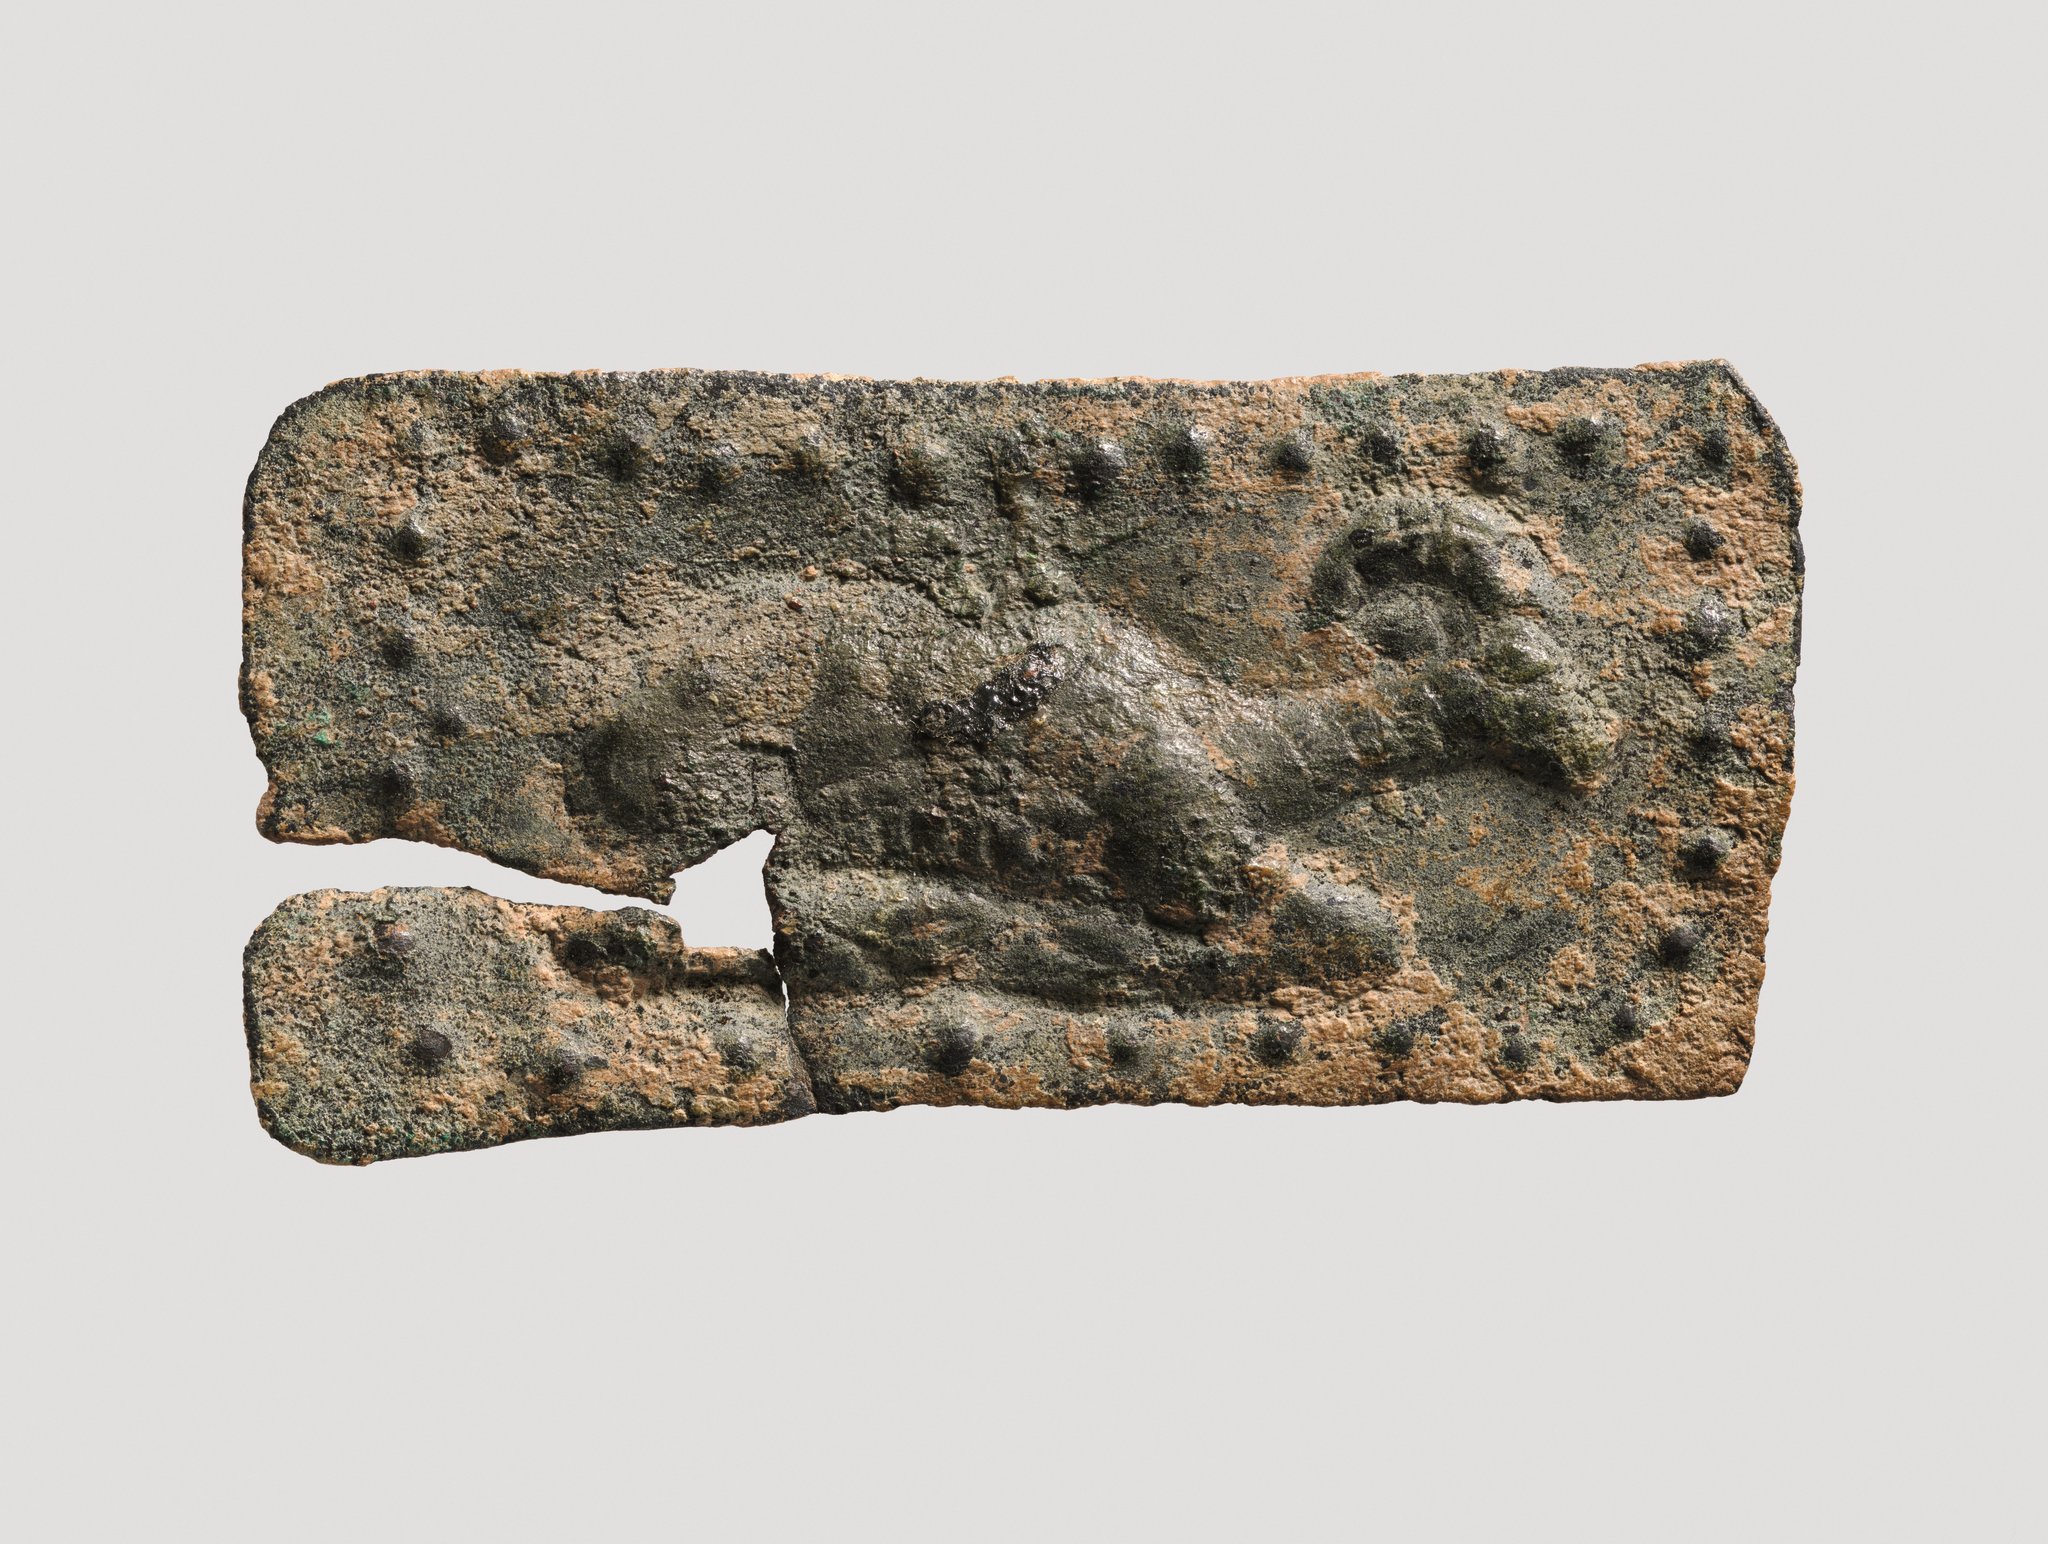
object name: relief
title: Plaque with horned animal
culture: iranian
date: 800-601 BCE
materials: bronze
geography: iran, luristan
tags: animals